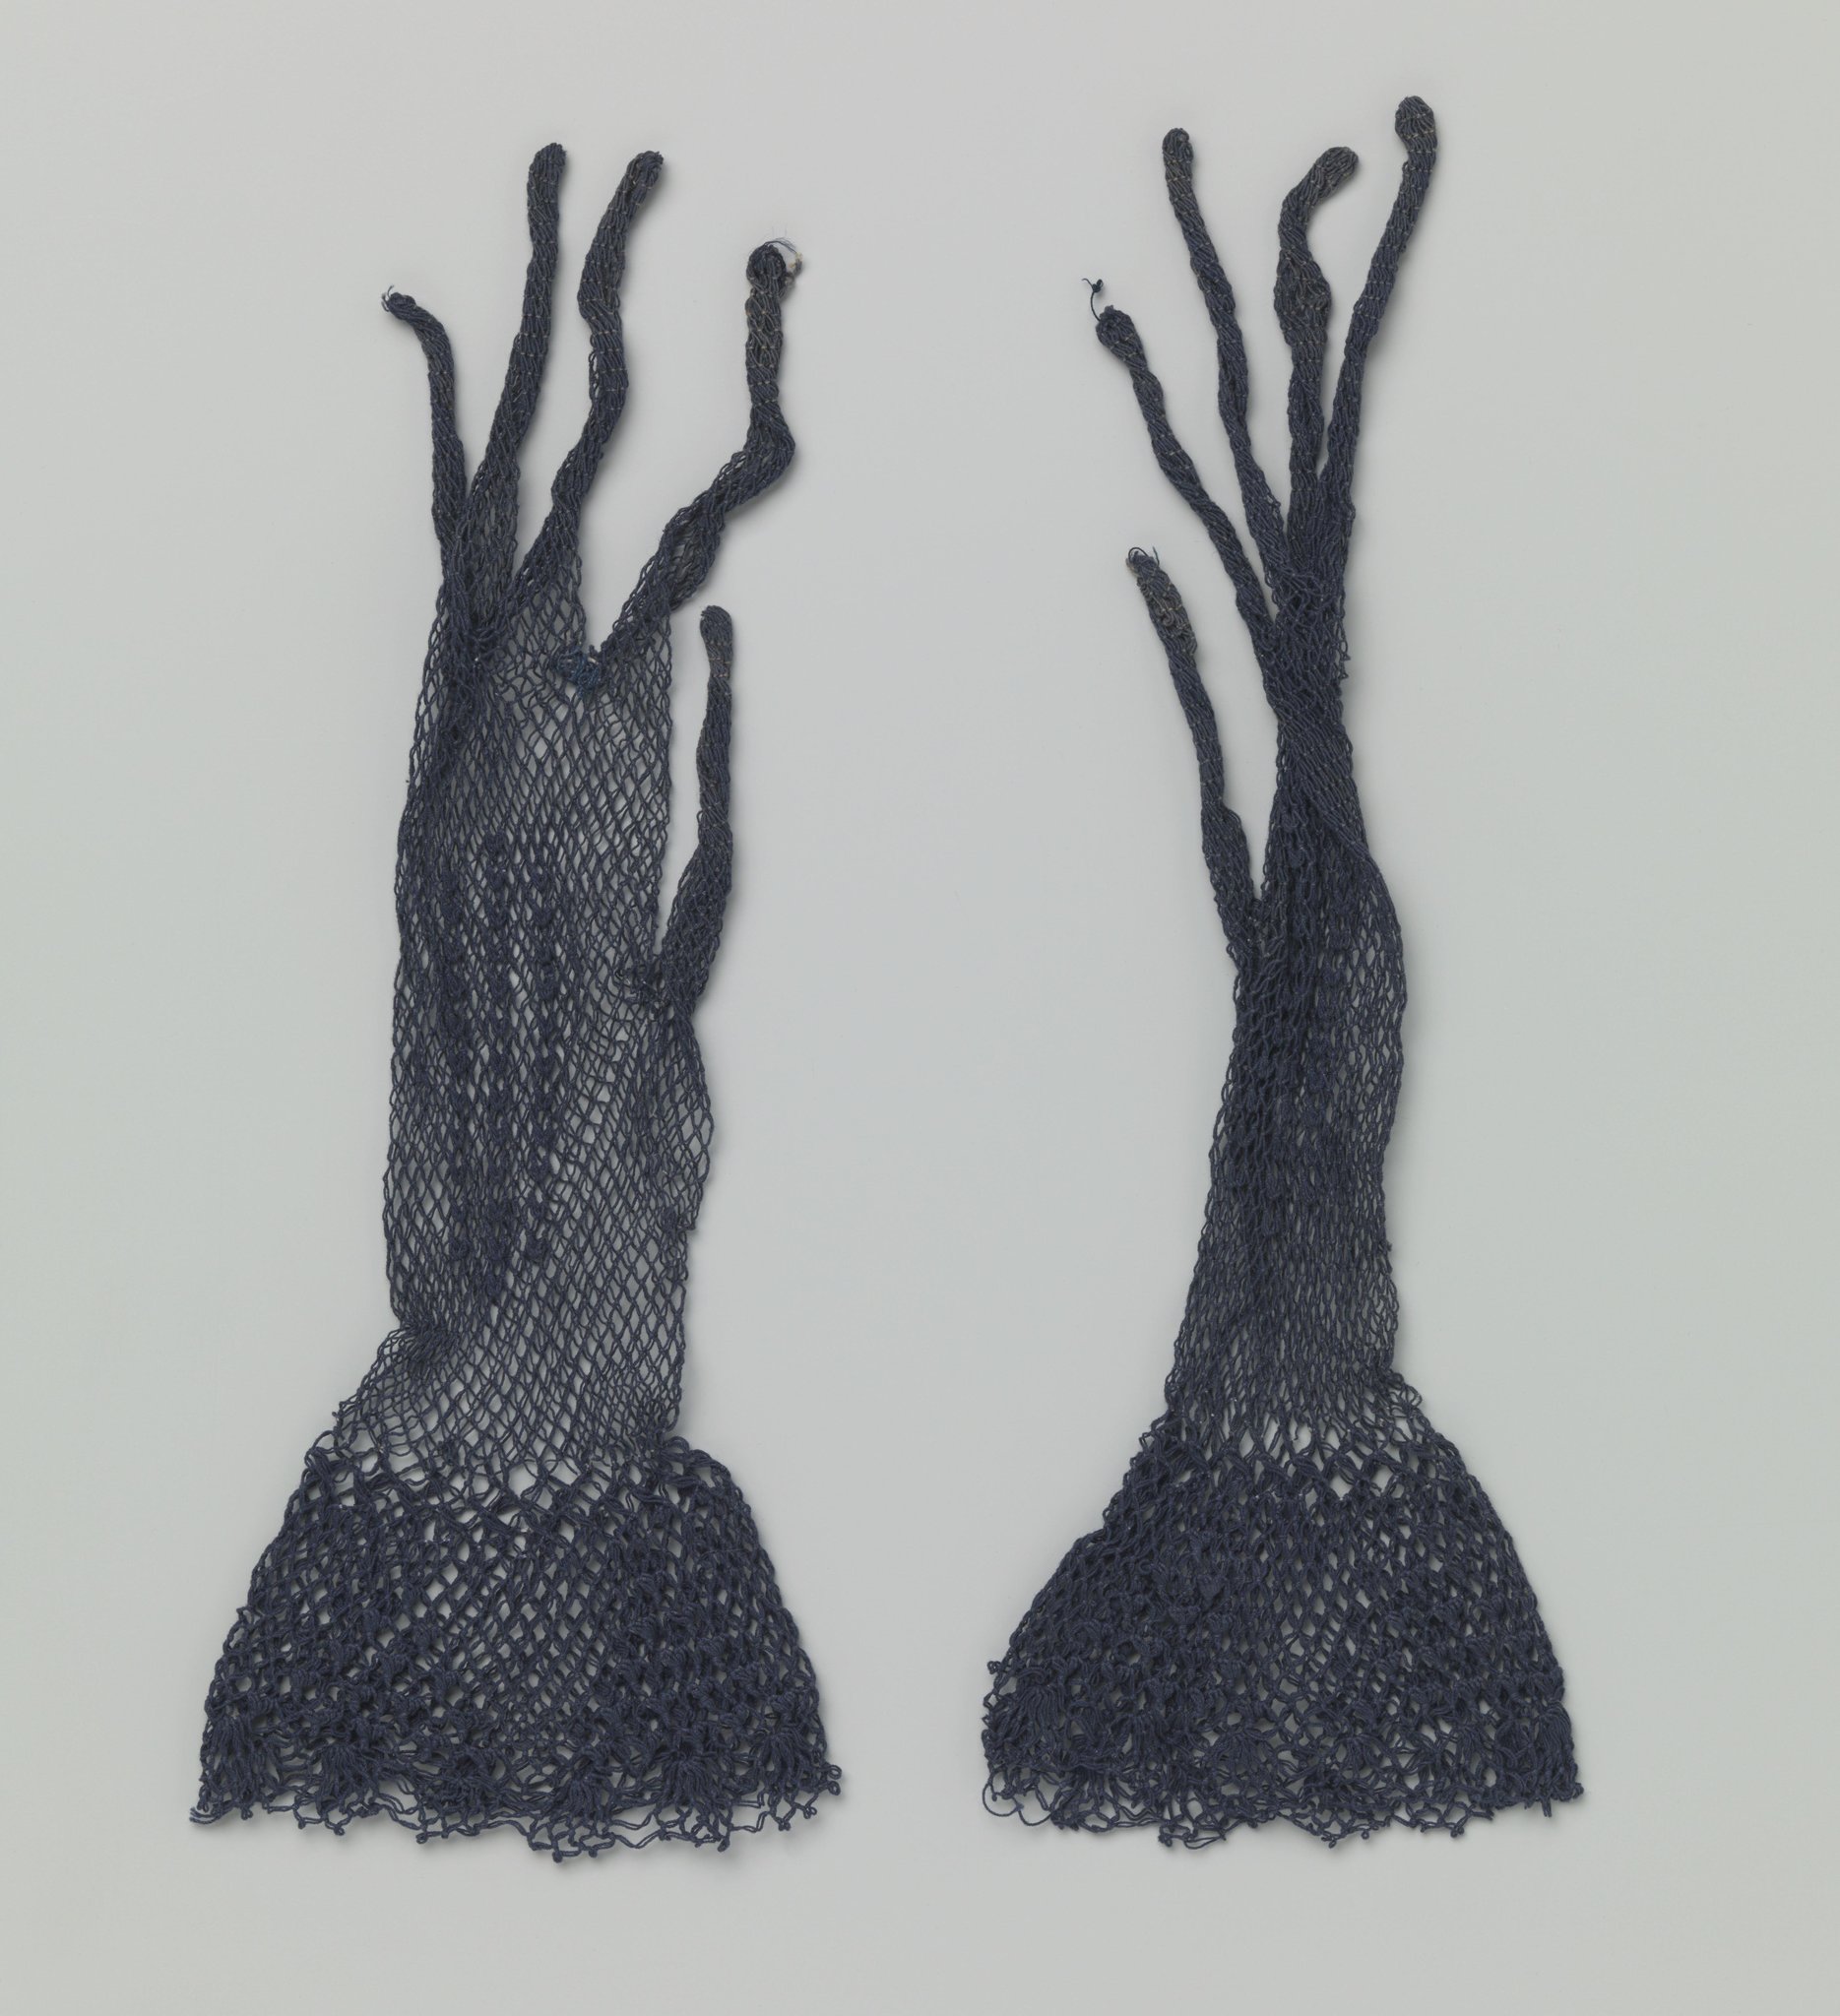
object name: glove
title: Rechterhandschoen van blauw katoen in Egyptisch vlechtwerk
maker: Anonymous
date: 1910-1925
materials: cotton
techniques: sprang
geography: netherlands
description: Rechterhandschoen van blauw katoen in Egyptisch vlechtwerk.